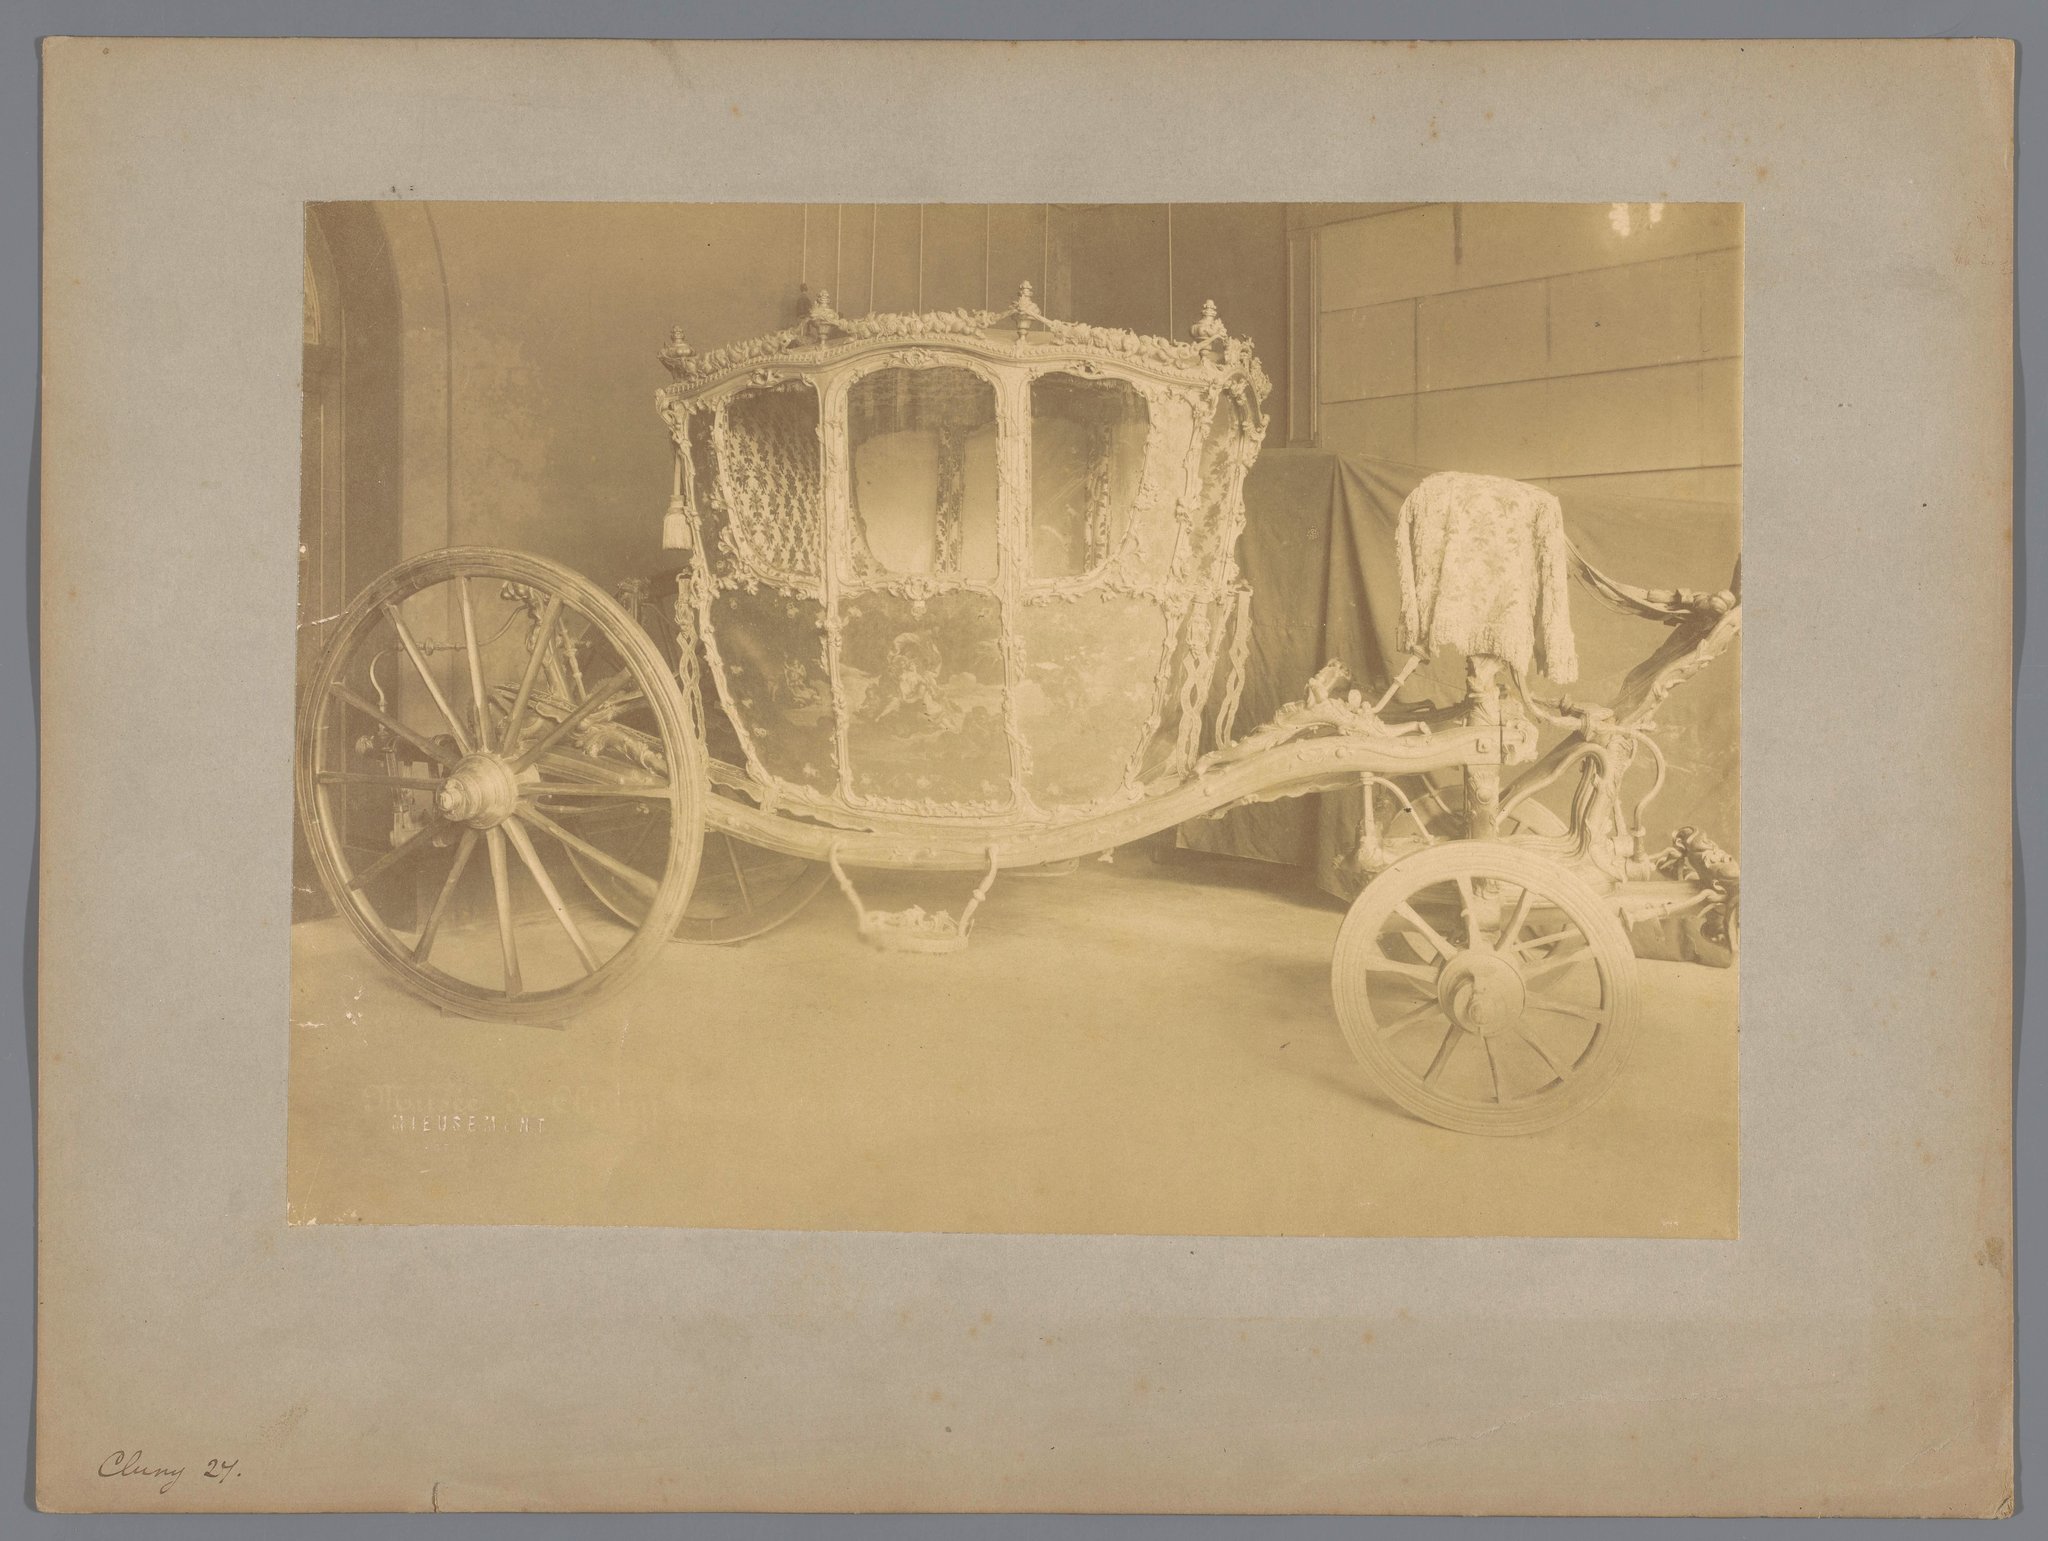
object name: photograph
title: Musée de Cluny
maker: séraphin-médéric mieusement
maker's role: fotograaf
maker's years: 1840-1905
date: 1850-1900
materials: cardboard, photographic support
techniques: albumen print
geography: paris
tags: passenger carriage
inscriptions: workshop stamp: ‘Mieusement/ Photographe’, number: ‘Cluny 24’, collector's mark: ‘Rijks-normaalschool voor teekenonderwijzers Amsterdam’ Lugt 3937